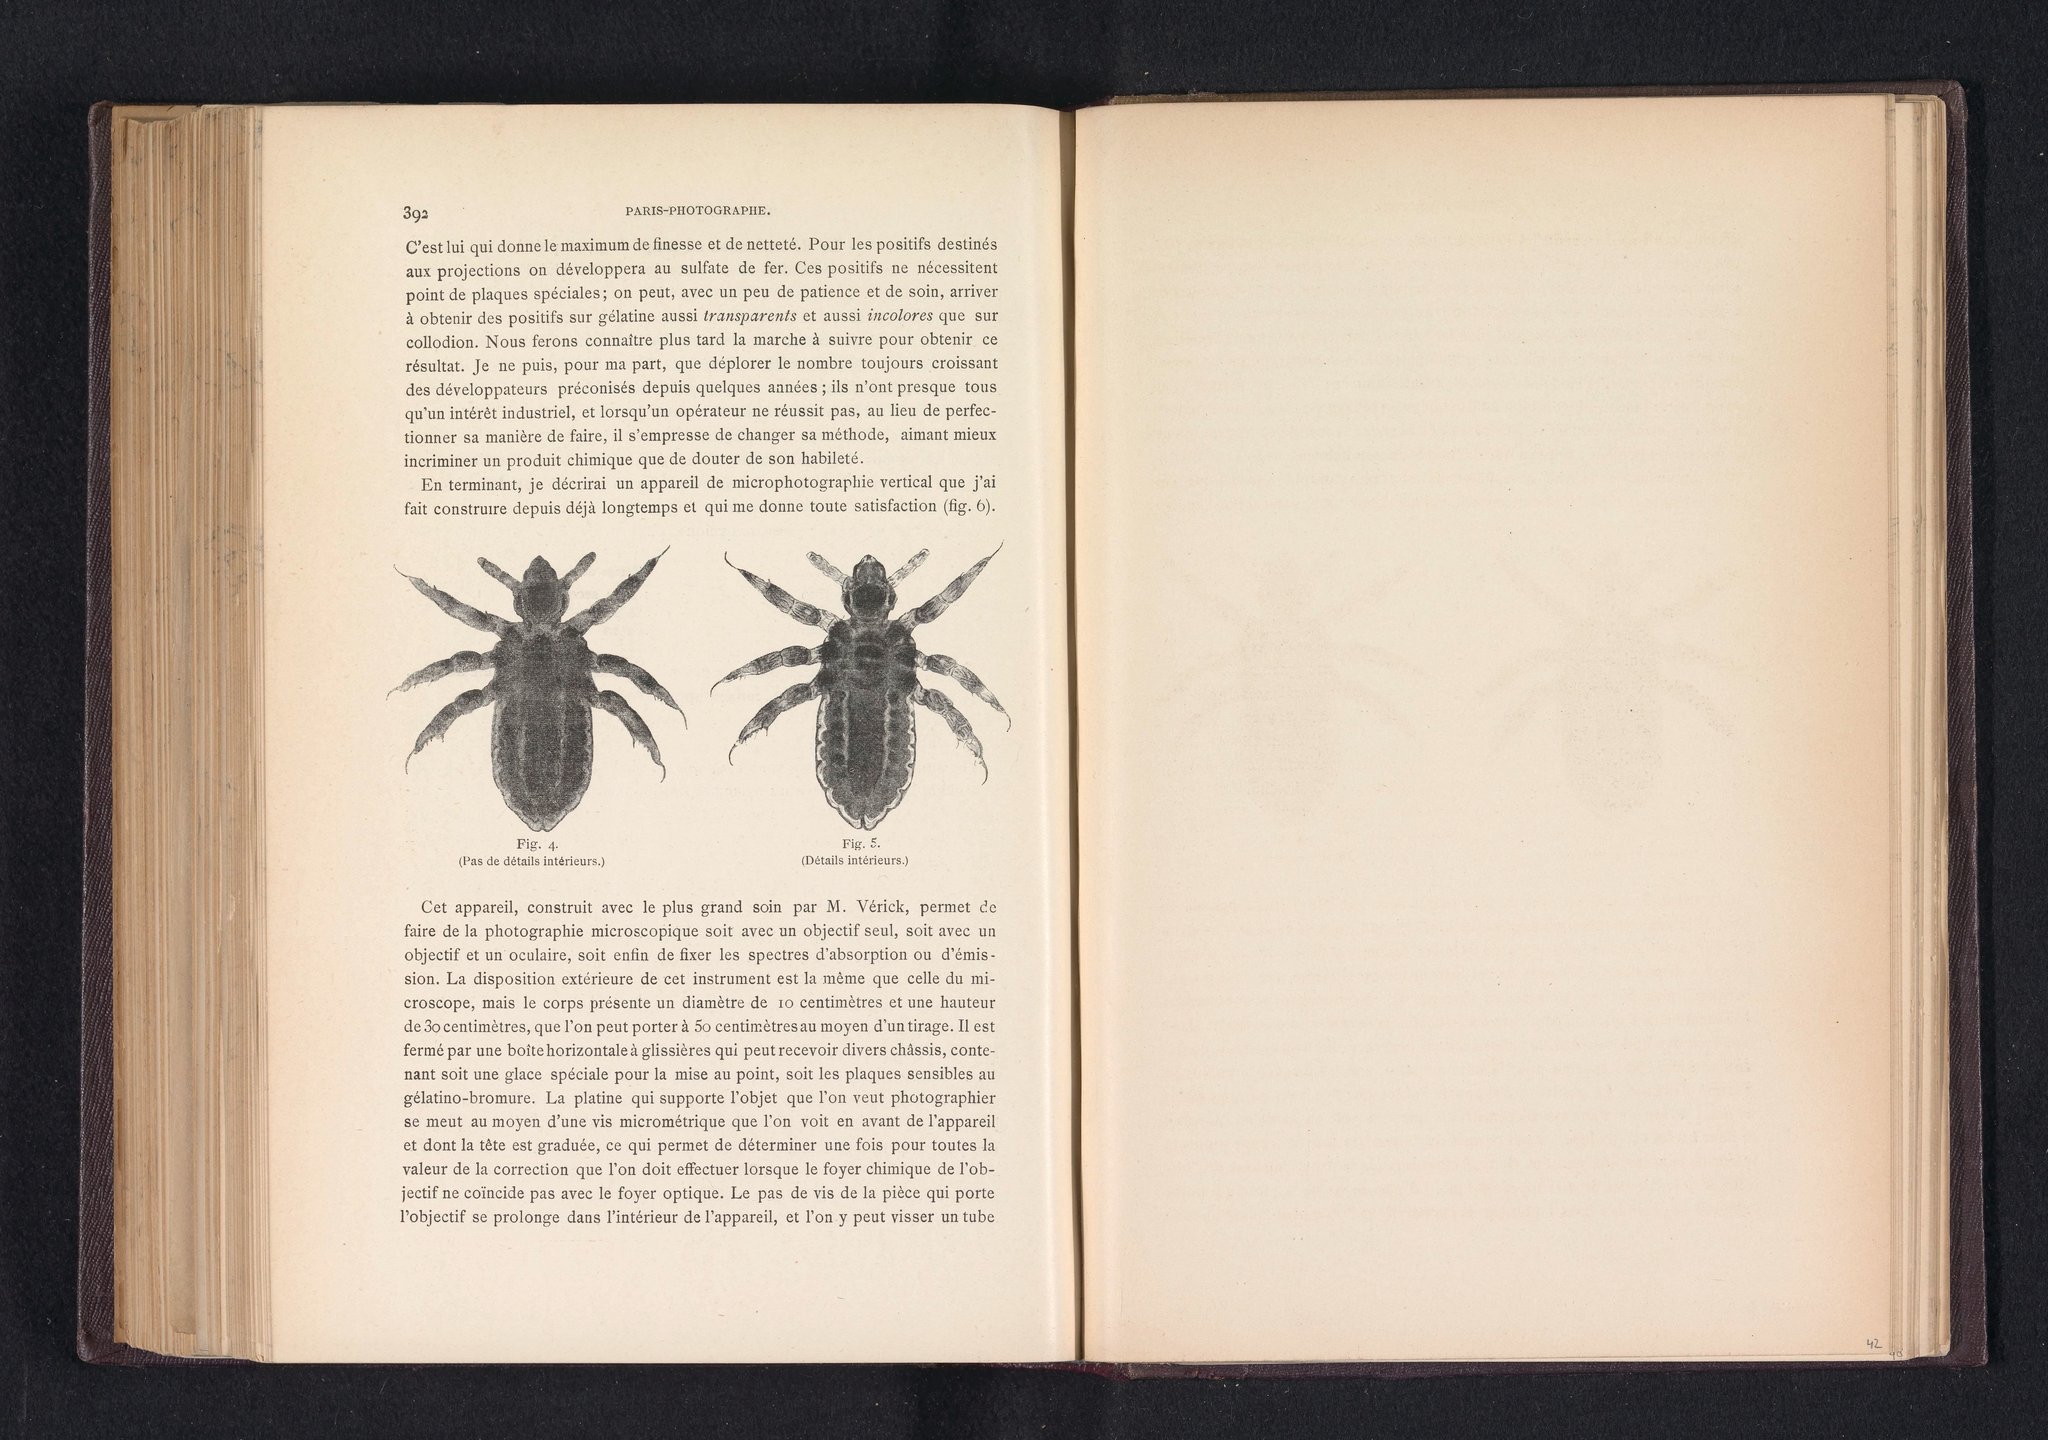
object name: page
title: Luizen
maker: Anonymous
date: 1881-1891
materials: paper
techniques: autotype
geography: france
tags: insects: louse